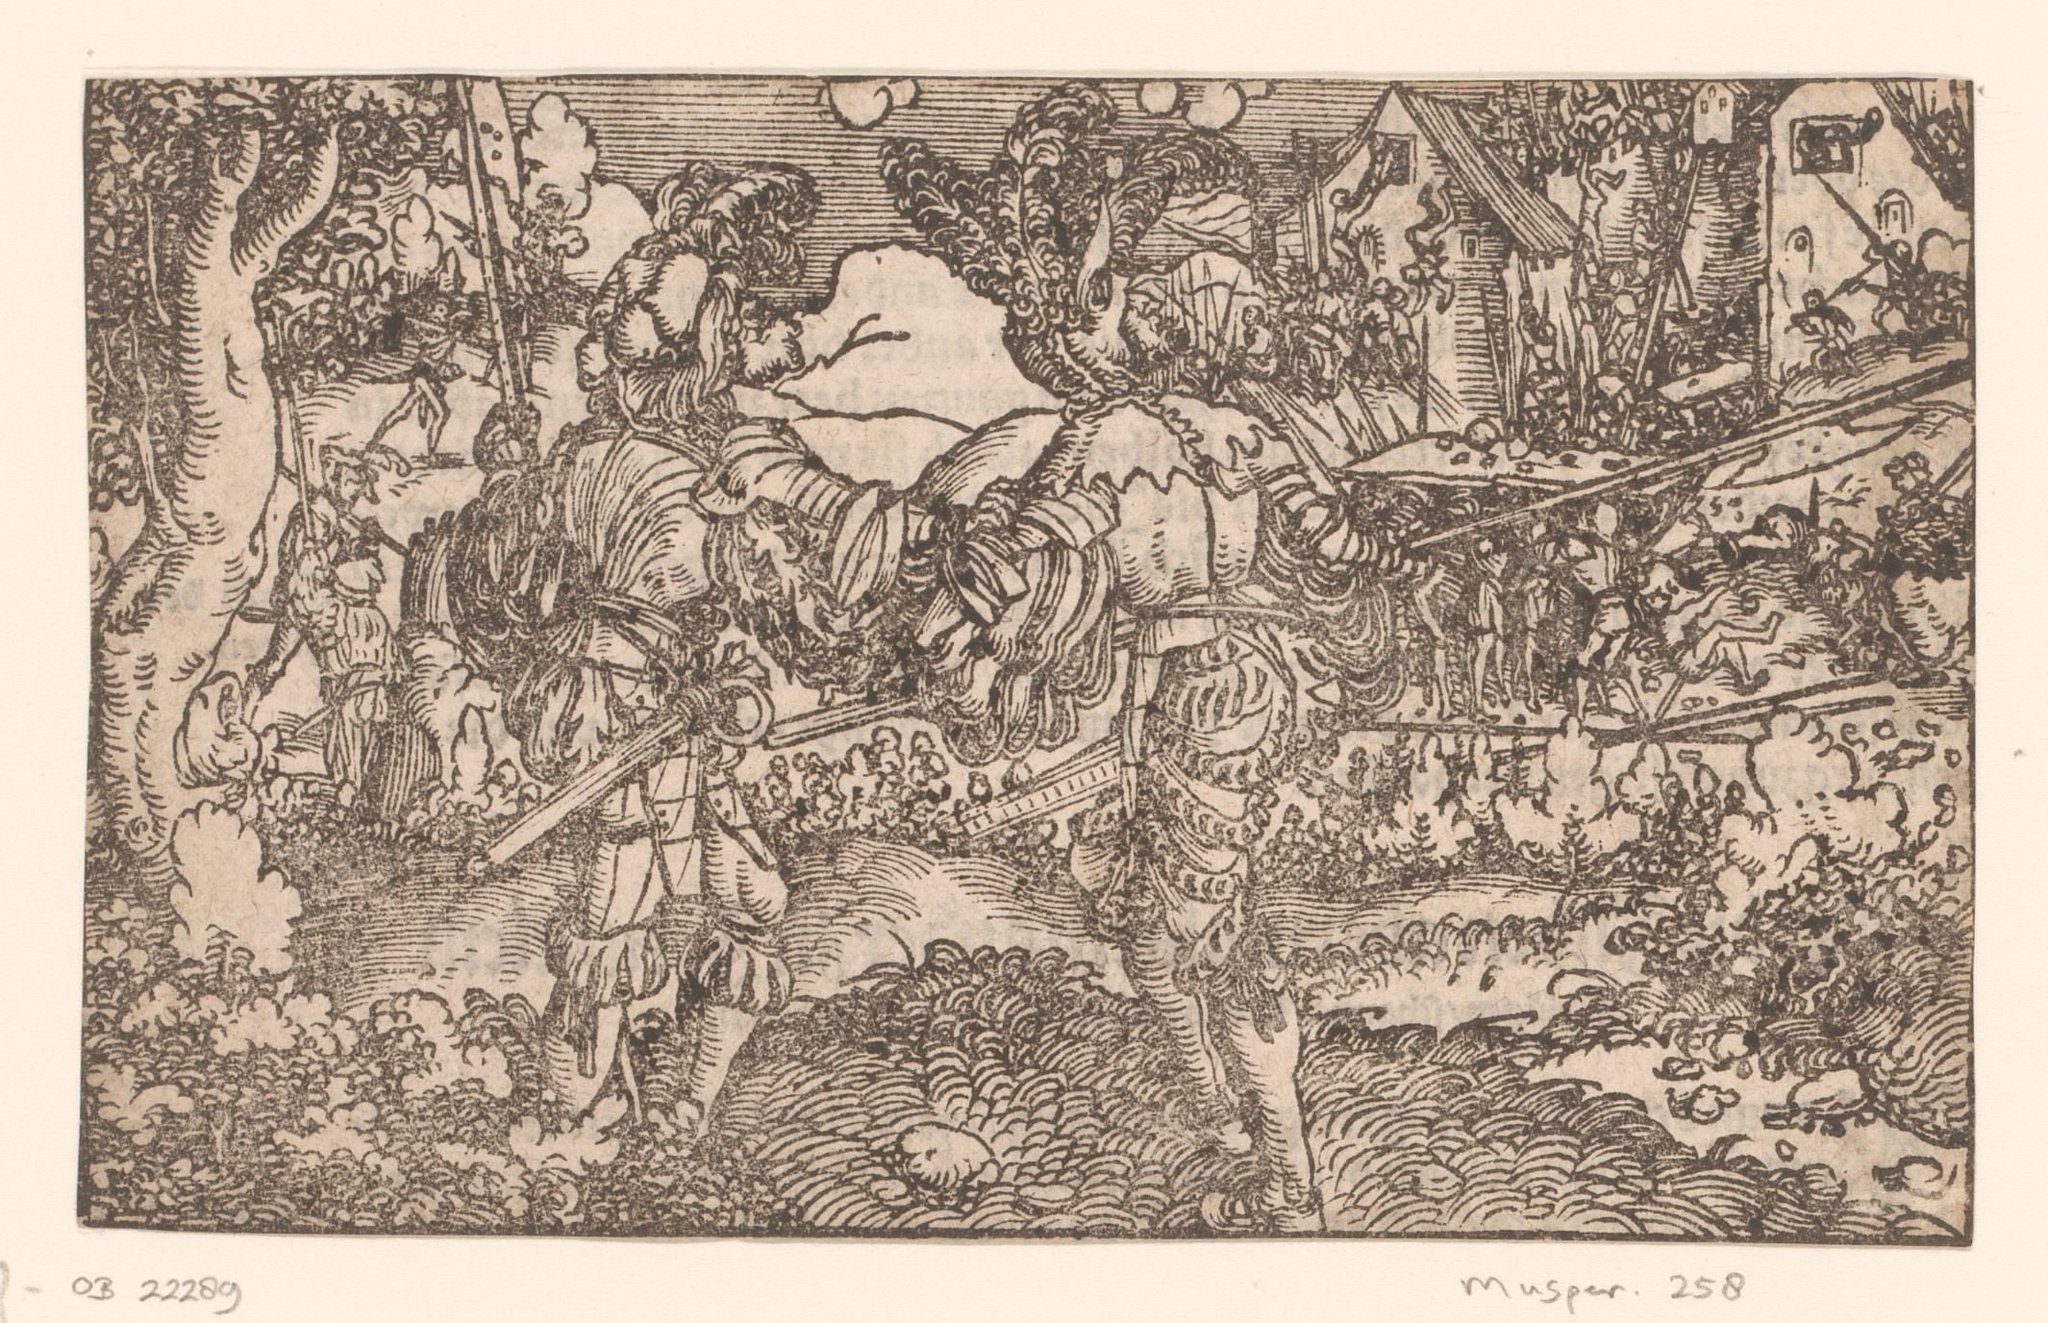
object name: print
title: Twee legeraanvoerders gekleed als landsknechten twistend over de juiste manier om een stad te belegeren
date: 1532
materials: paper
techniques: woodcut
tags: command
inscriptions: collector's mark: Lugt 240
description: Prent voor het eerst gebruikt in: Petrarca, Francesco. Von der Artzney bayder Glück. Augsburg: Heinrich Steiner, 1532.